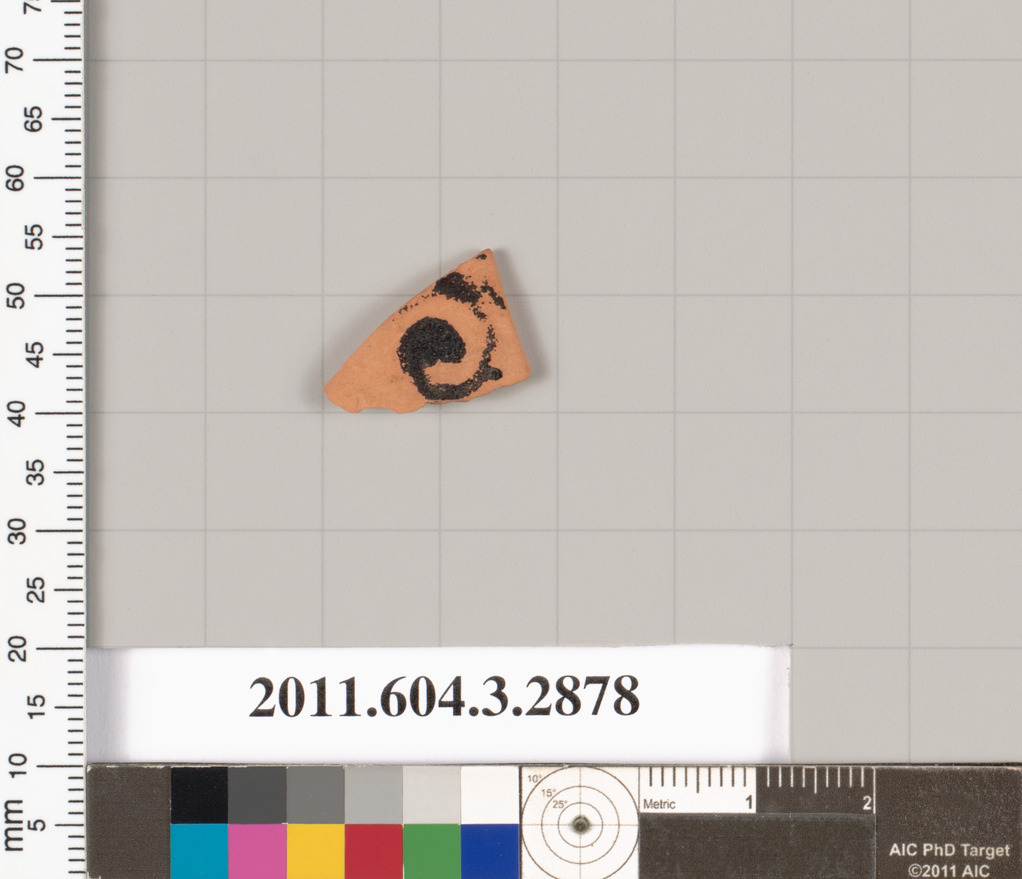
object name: undetermined closed shape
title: Terracotta fragment of a closed shape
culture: greek, attic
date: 600-501 BCE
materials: terracotta